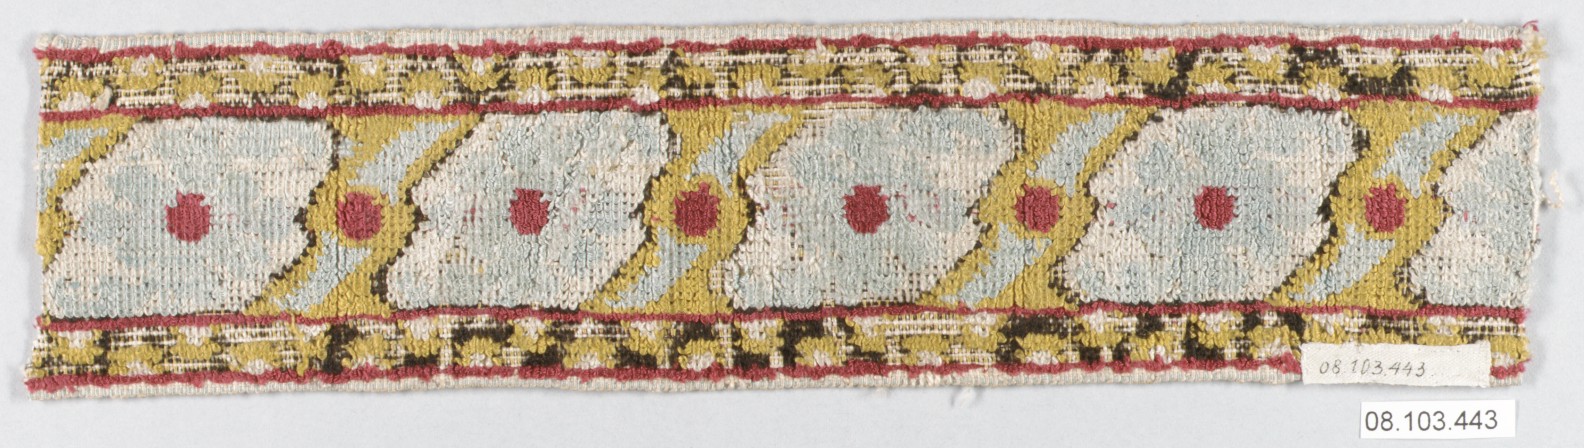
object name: galloon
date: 1801-1900